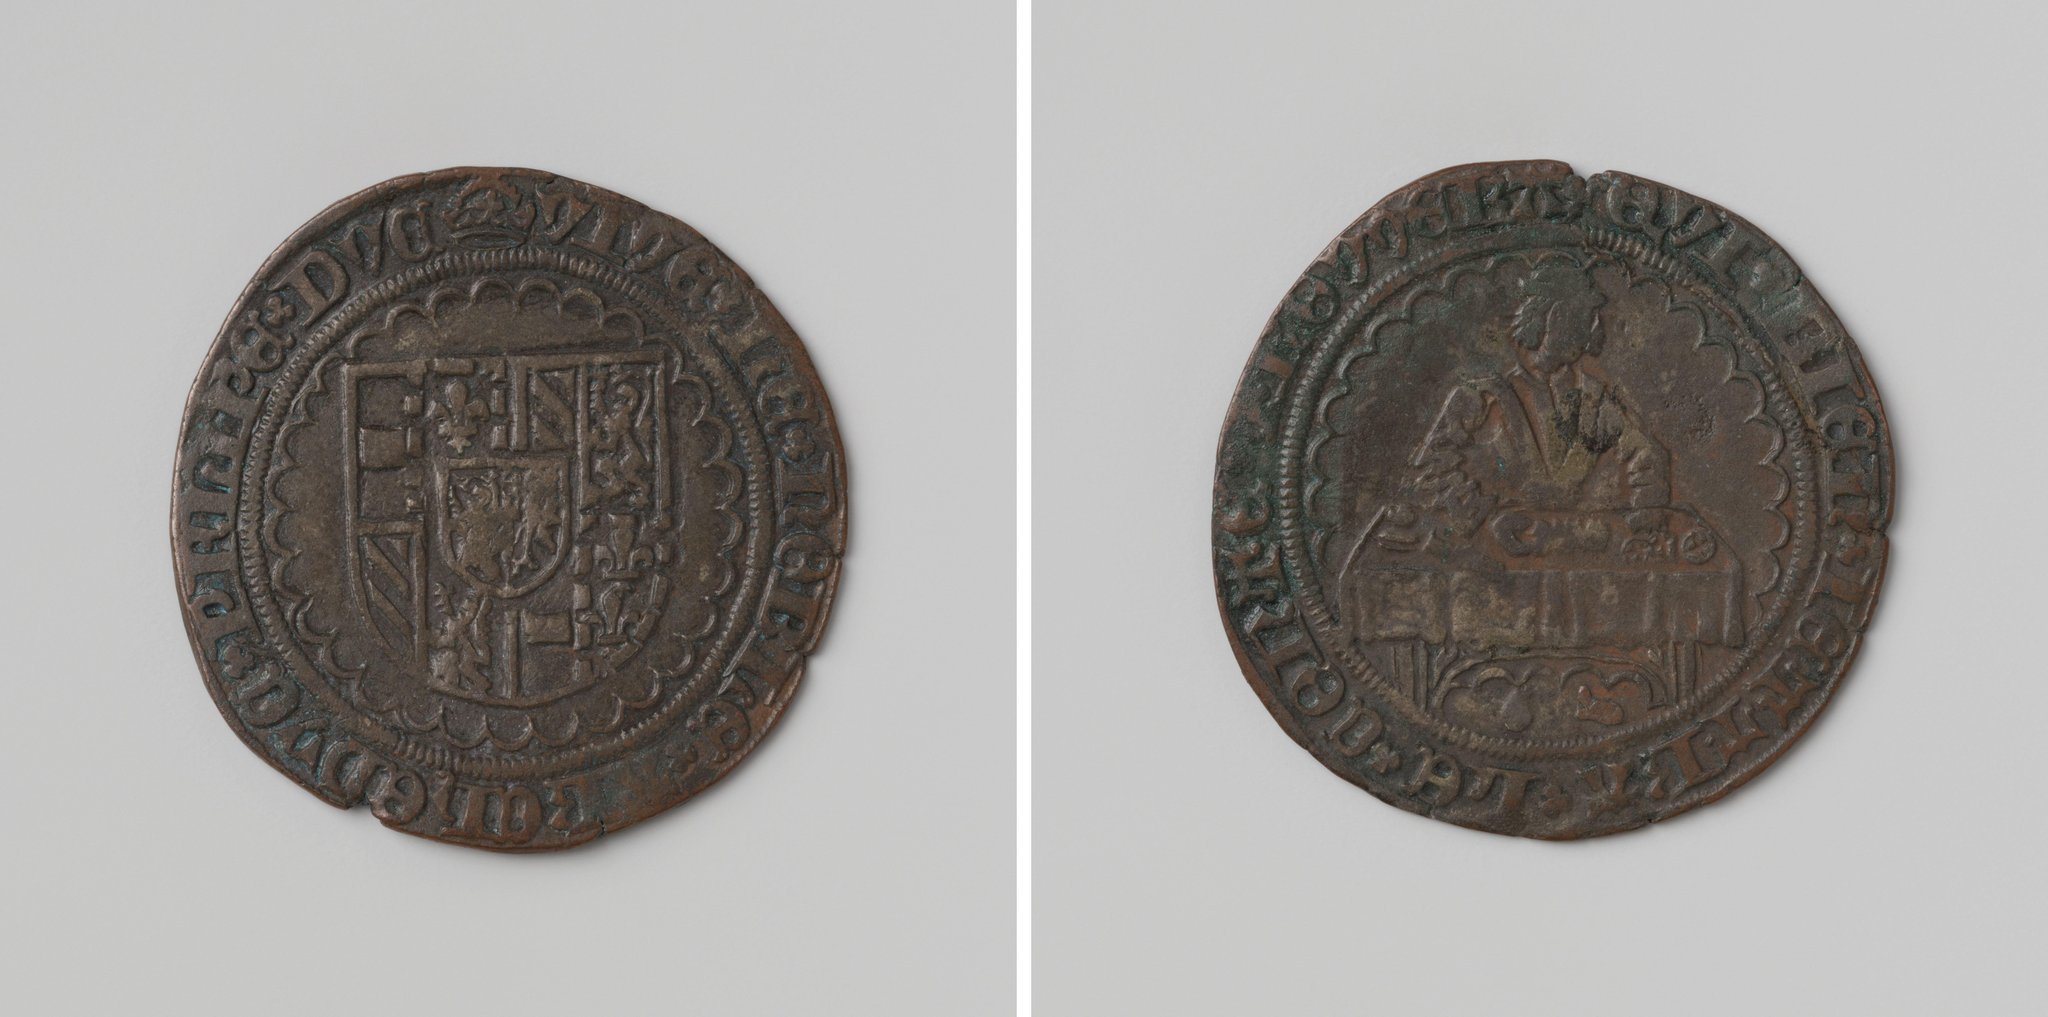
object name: jeton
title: Filips de Schone, aartshertog van Oostenrijk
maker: Anonymous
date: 1494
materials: copper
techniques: striking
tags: bruges, filips de schone (hertog van bourgondië)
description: Koperen penning. Voorzijde: wapenschild binnen cirkel, opgebouwd uit verschillende bogen en omschrift. Keerzijde: man, zittend aan tafel, bezig met tellen van geld of rekenpenningen binnen cirkel, opgebouwd uit verschillende bogen en omschrift